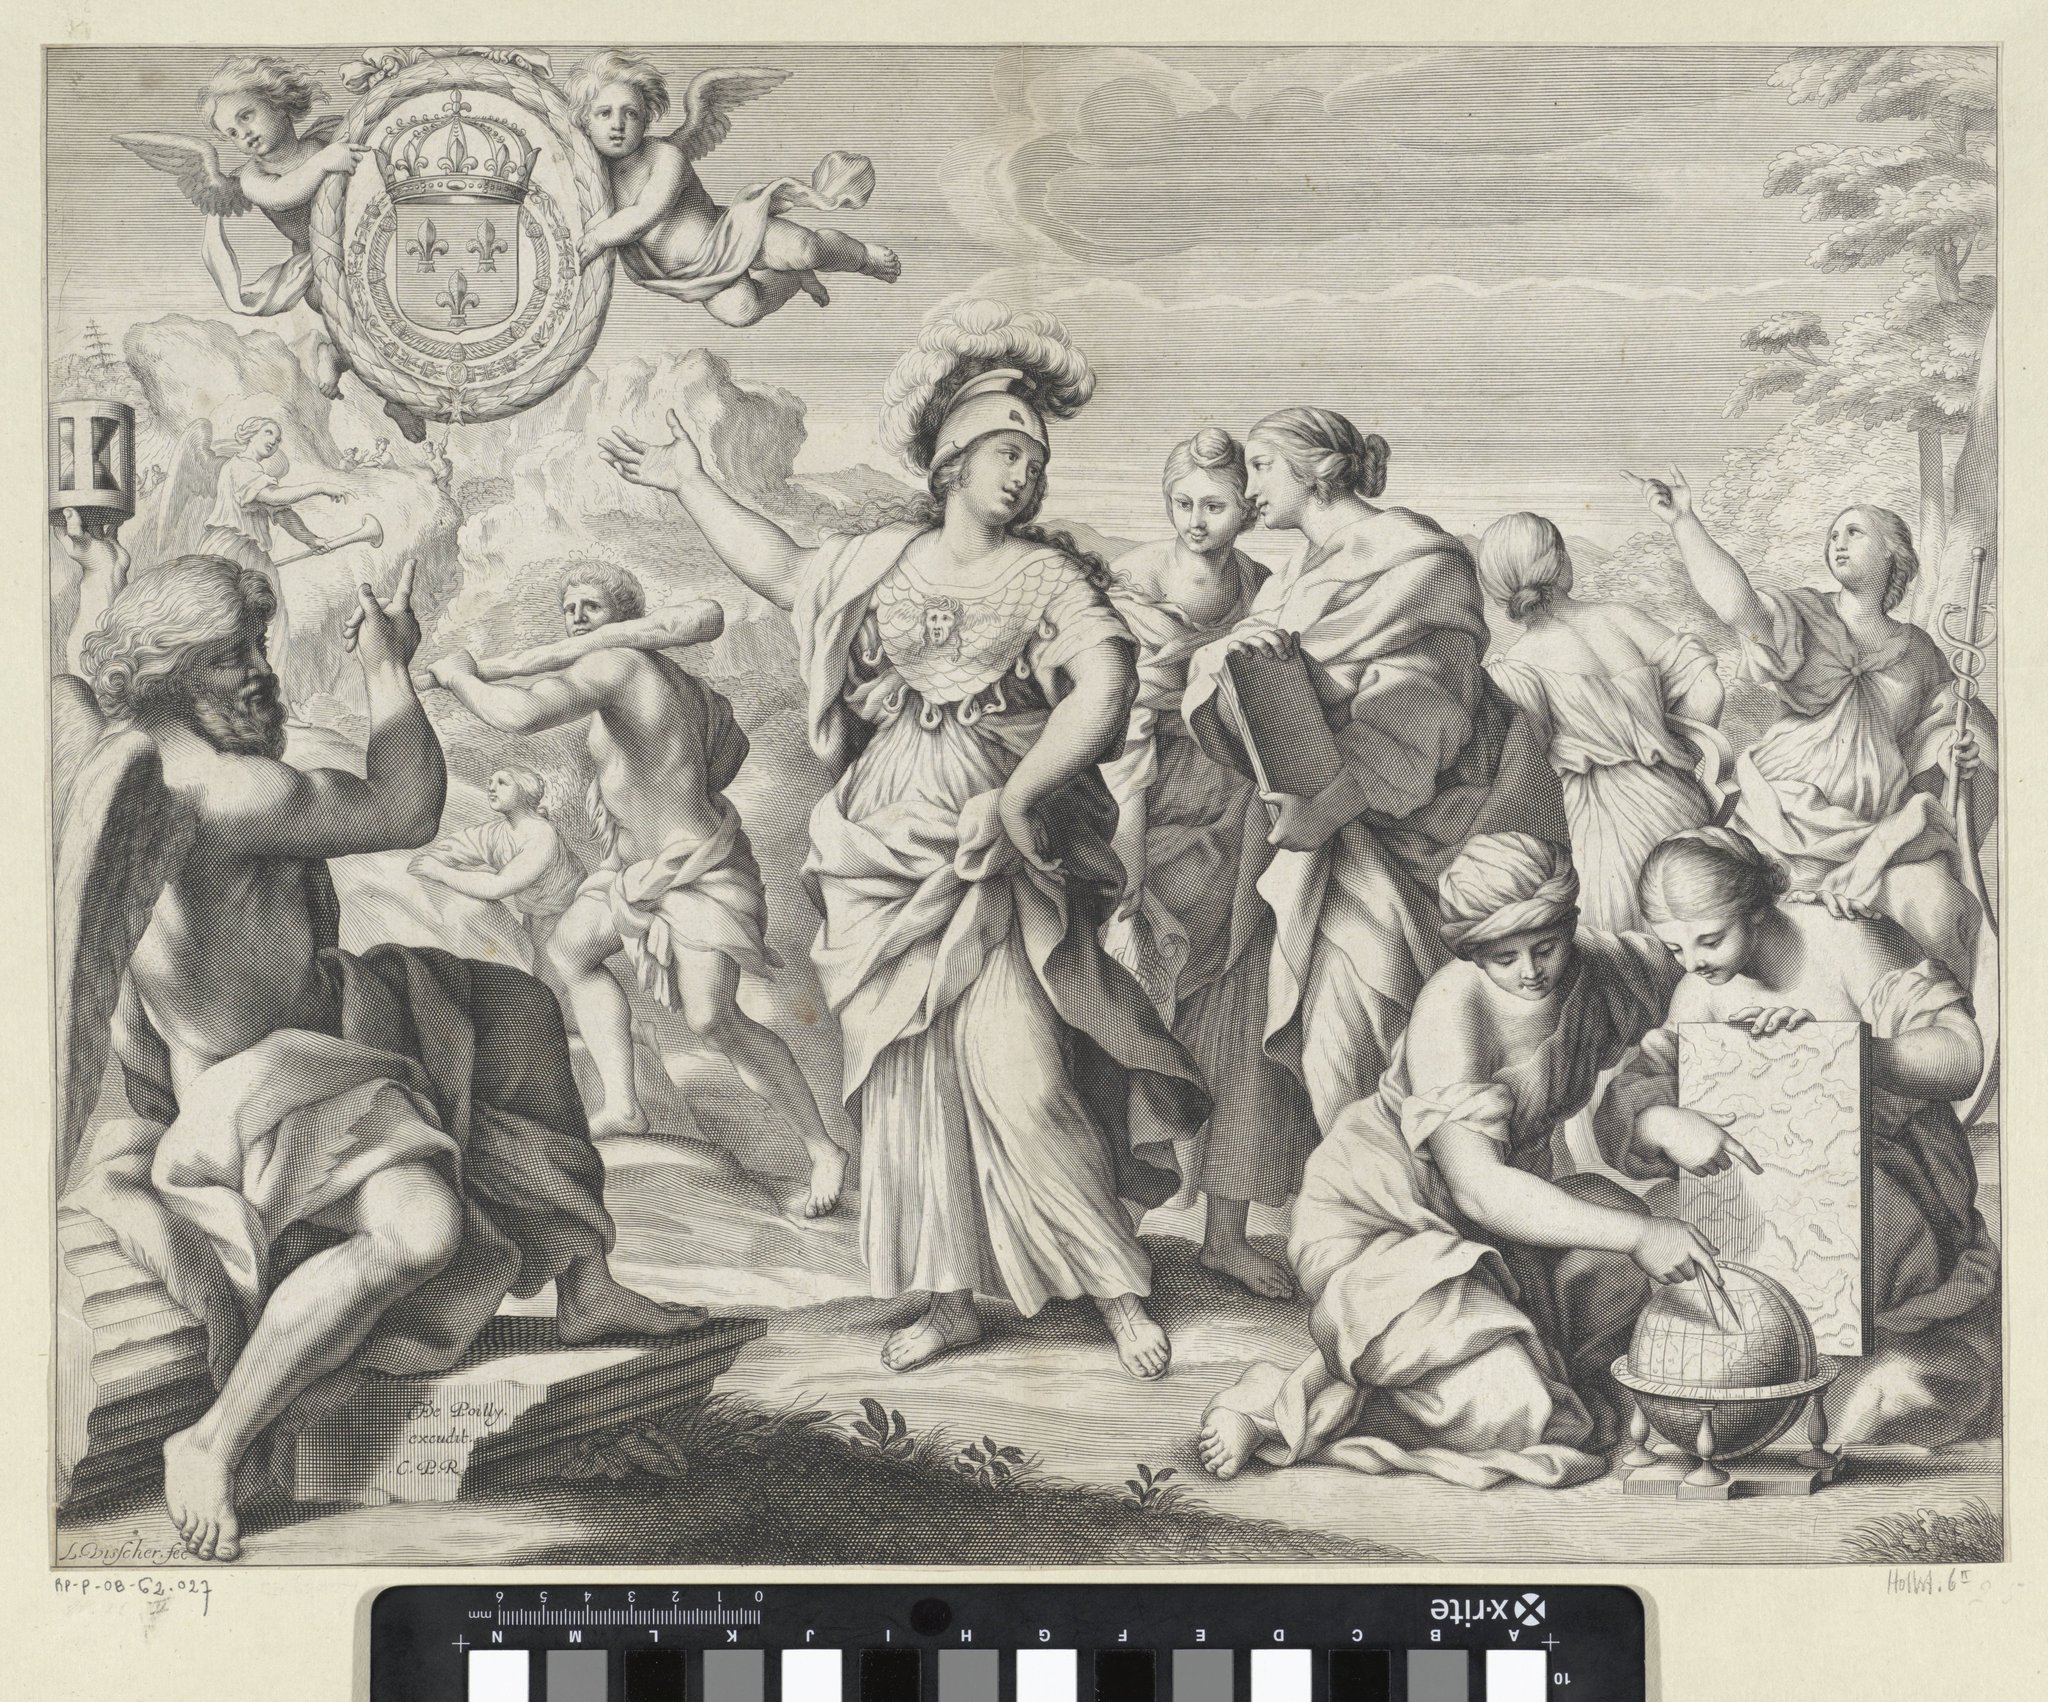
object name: print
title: Allegorie op de Deugd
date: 1643-1723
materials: paper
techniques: engraving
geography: paris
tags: (story of) hercules (heracles), (story of) minerva (pallas, athena), maps, atlases, compasses, globe, cupids: 'amores', 'amoretti', 'putti', father time, man with wings and scythe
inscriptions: collector's mark: Lugt 240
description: Minerva en Vader Tijd wijzen op de berg van Deugd op de achtergrond. Hercules wijst de weg. Rechts op de voorgrond bestuderen twee vrouwen een globe en een kaart.